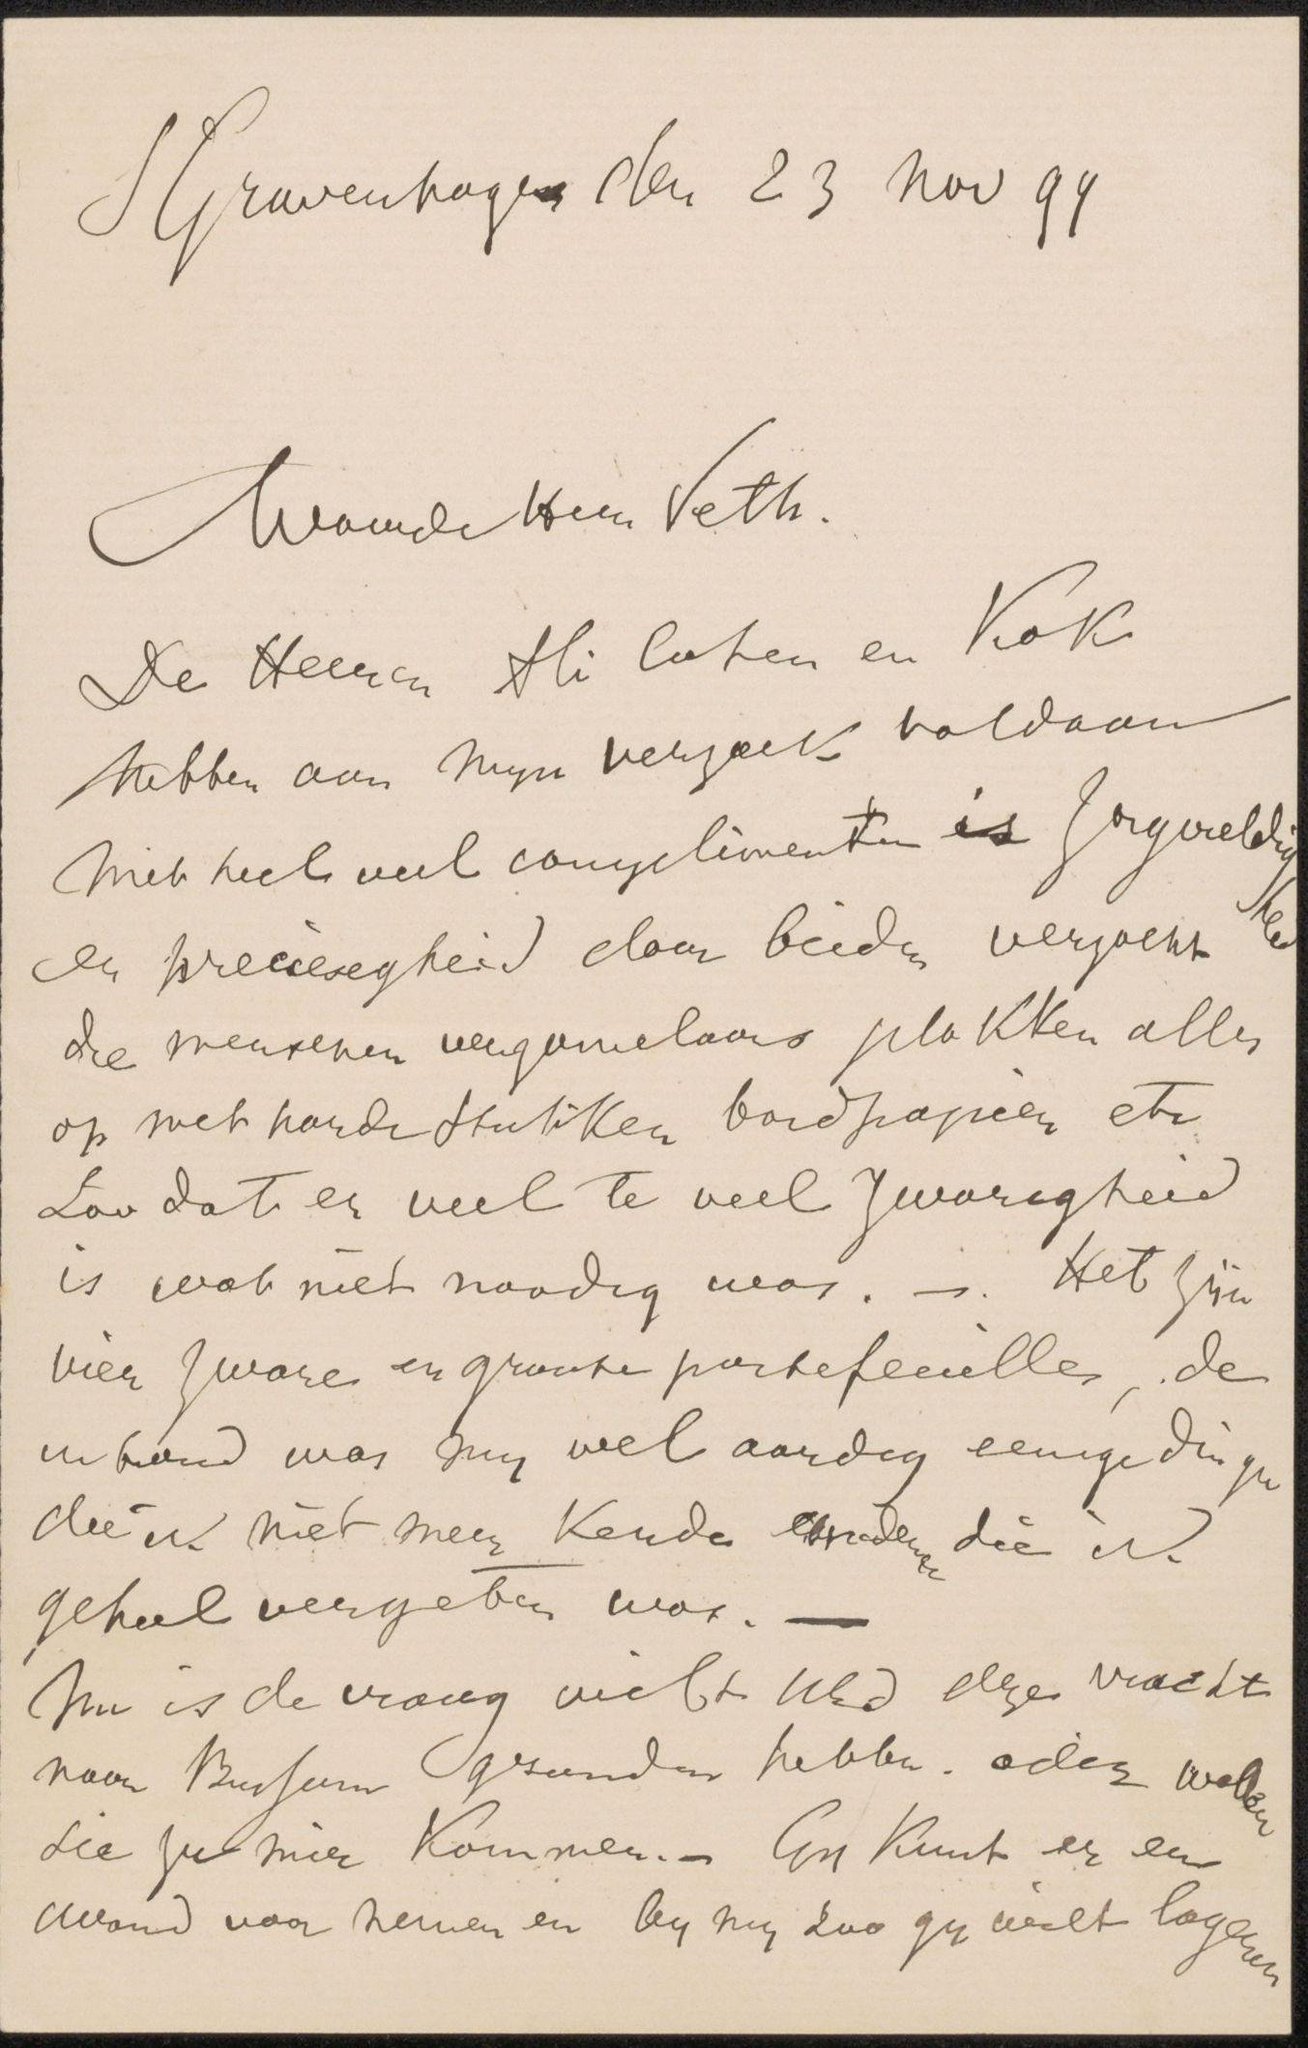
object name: letter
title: Brief aan Jan Veth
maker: jozef israëls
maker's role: draughtsman, painter, print maker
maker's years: 1824-1911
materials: ink, paper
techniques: pen, writing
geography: the hague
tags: dordrecht, amsterdam, painter, print maker, draughtsman, designer, jan veth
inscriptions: collector's mark: ‘RPK’